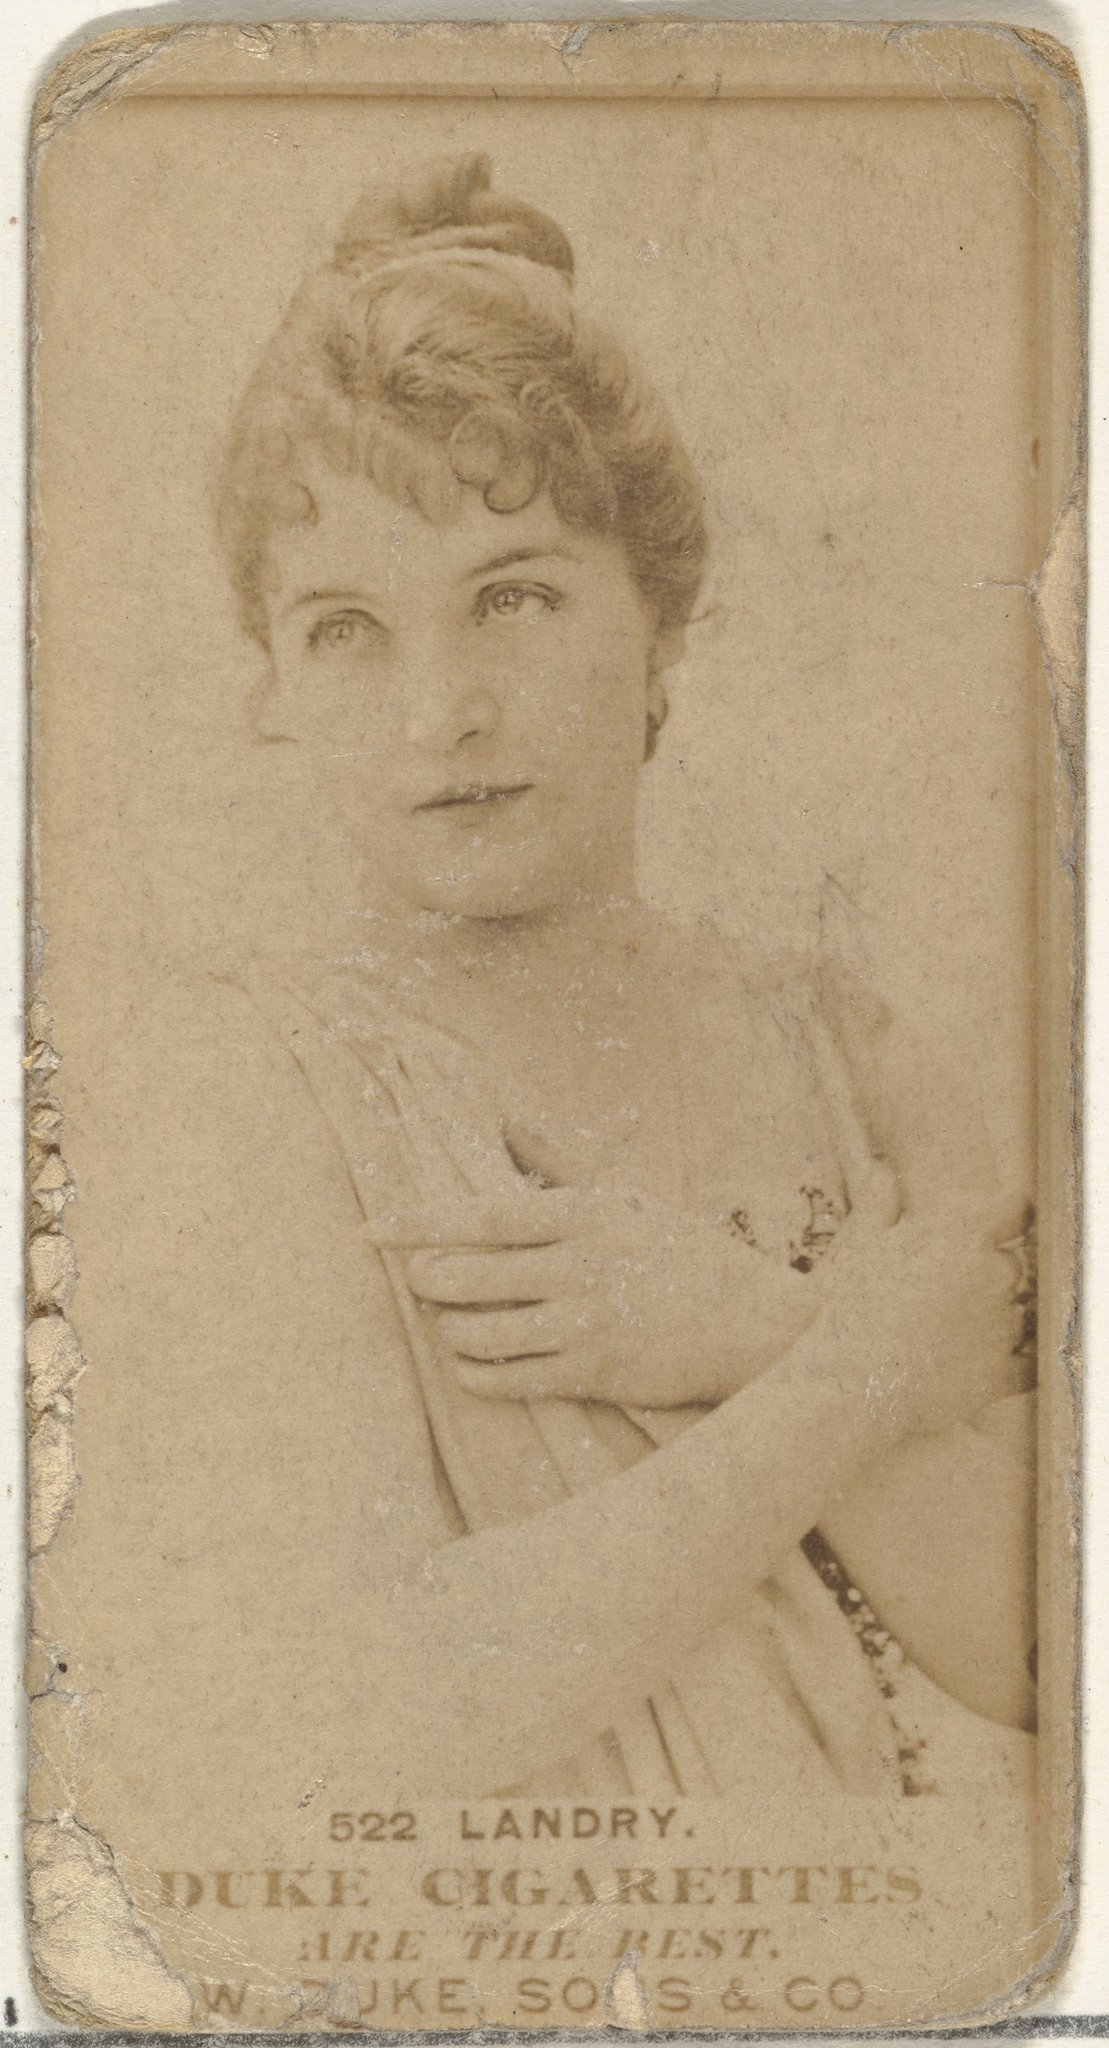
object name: photograph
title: Card Number 522, Miss Landry, from the Actors and Actresses series (N145-7) issued by Duke Sons & Co. to promote Duke Cigarettes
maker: w. duke, sons & co.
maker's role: publisher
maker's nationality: american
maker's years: 1870-1920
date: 1880-1889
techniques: albumen silver print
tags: portraits,women,actresses